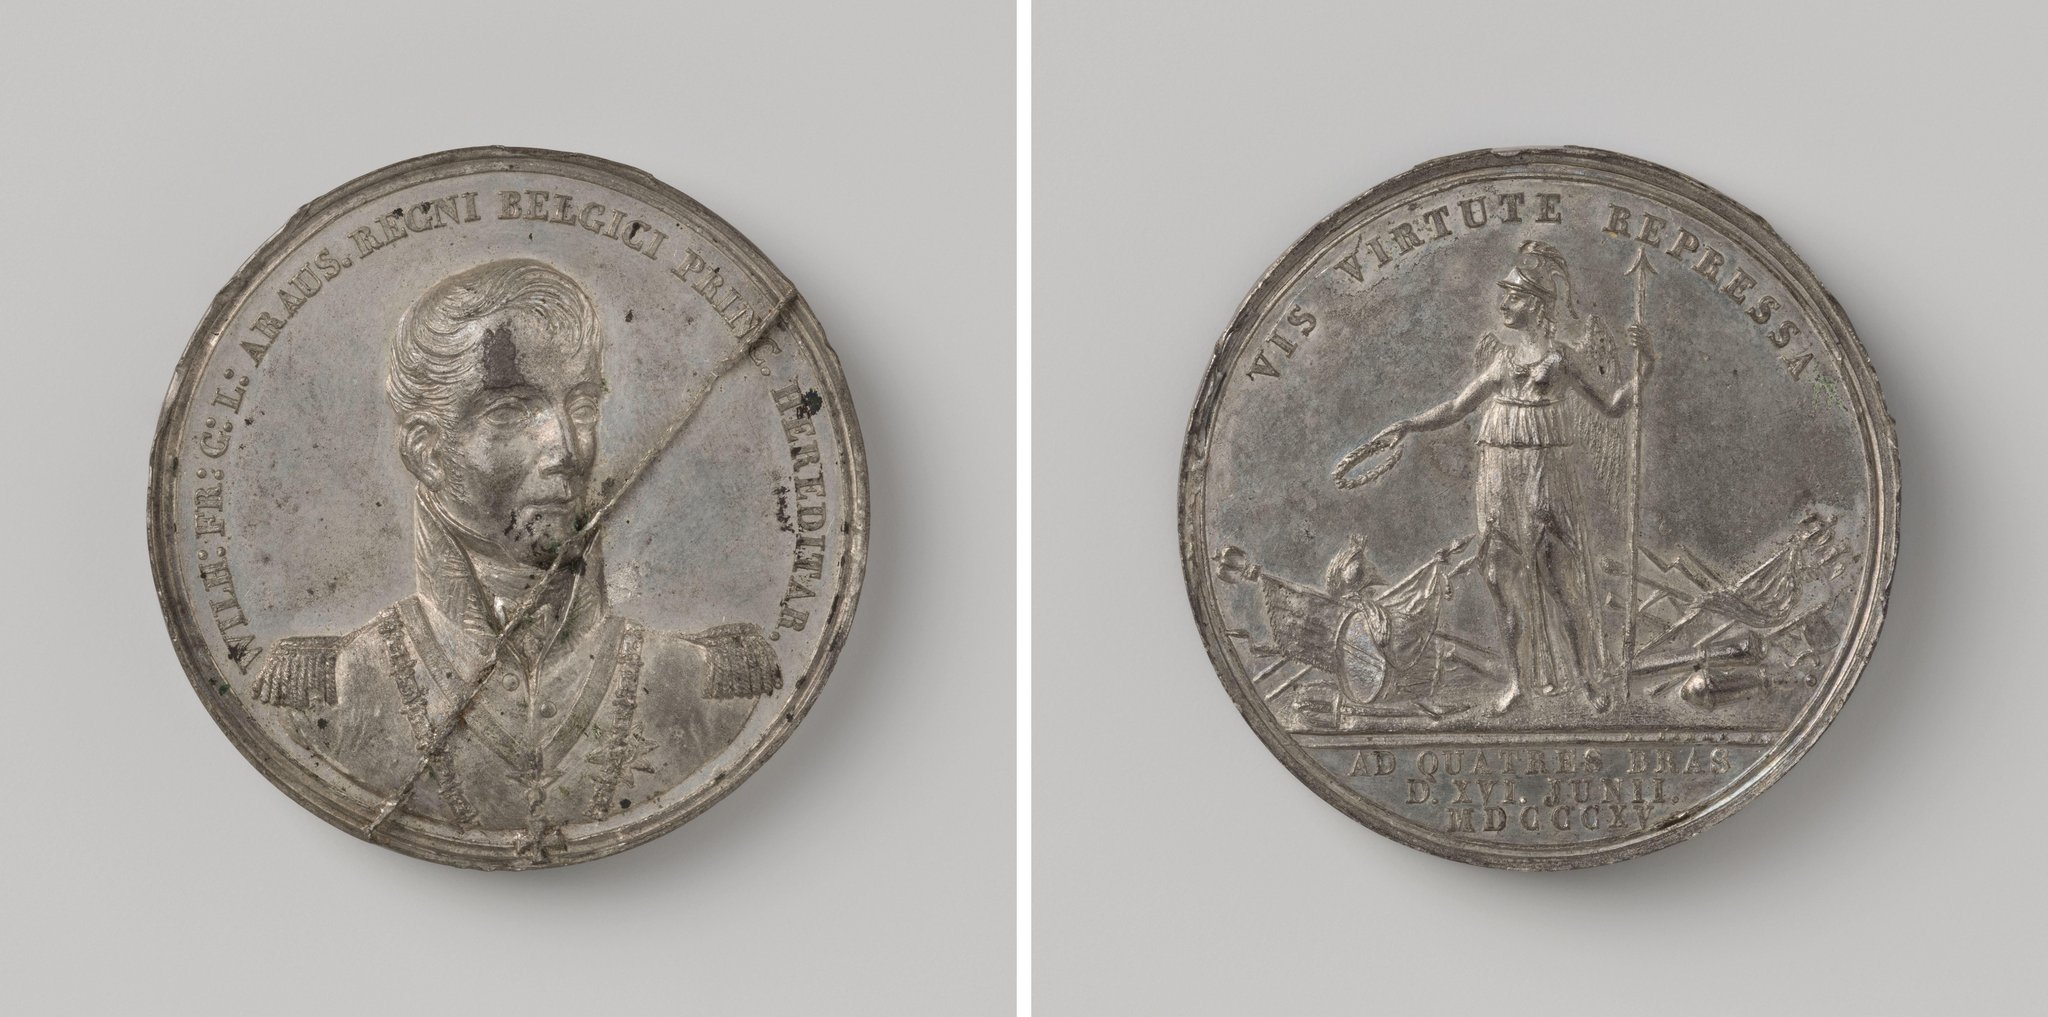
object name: history medal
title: Slag bij Quatre-Bras, ter ere van Willem Frederik George Lodewijk, erfprins der Nederlanden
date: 1815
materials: alloy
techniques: striking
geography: netherlands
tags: the hague, william ii of the netherlands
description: Slag bij Quatre-Bras (16 juni 1815), ter ere van Willem Frederik George Lodewijk, erfprins der Nederlanden. Penning. Voorzijde: borststuk man binnen omschrift. Keerzijde: gevleugelde Overwinning met helm, speer en lauwerkrans staande tussen veroverd wapentuig binnen omschrift; afsnede: opschrift.